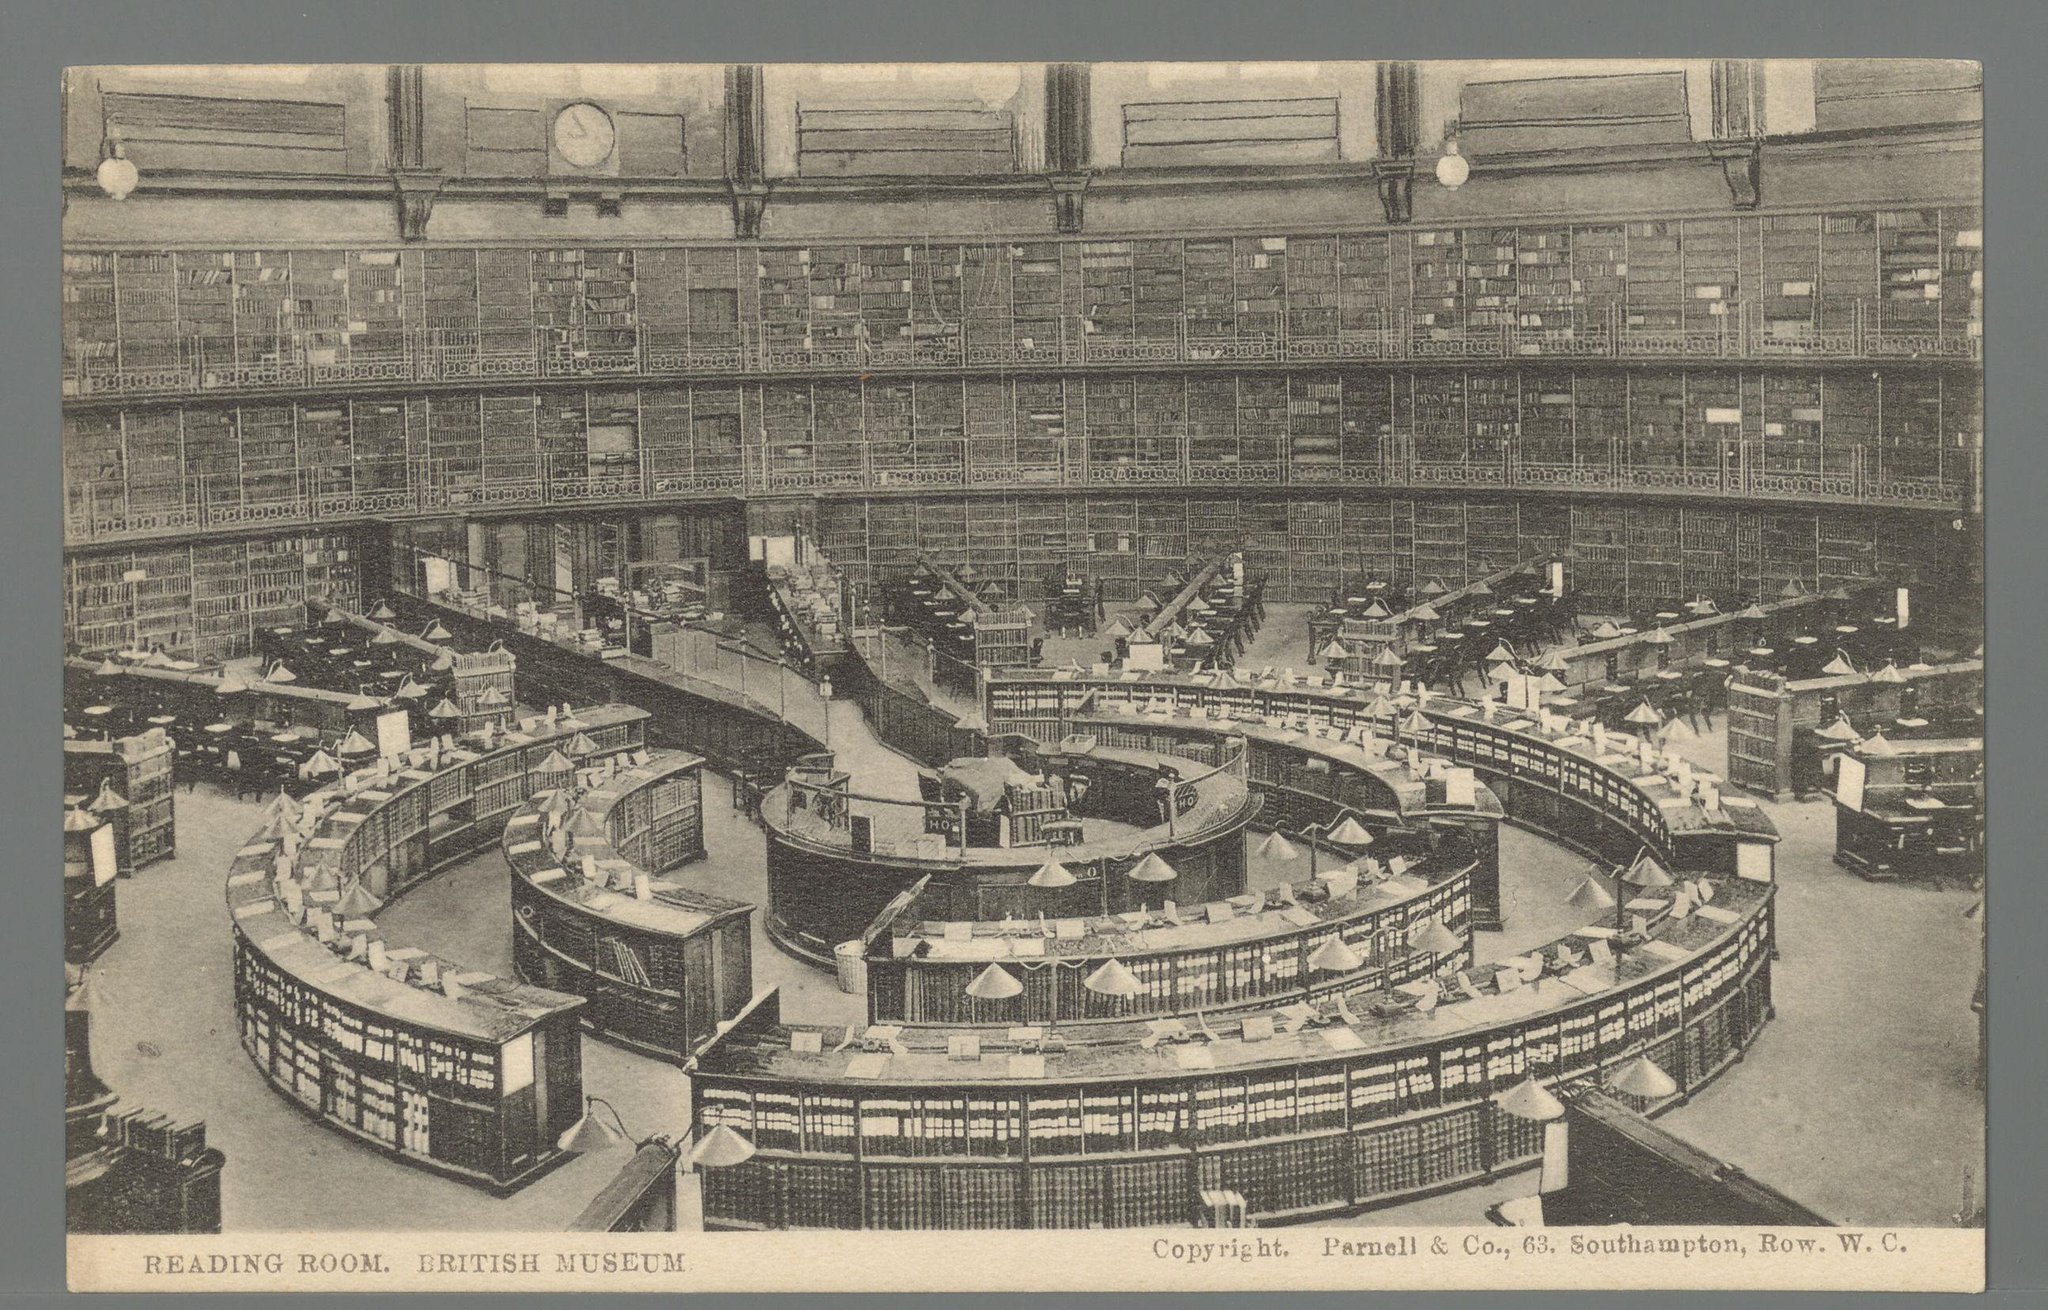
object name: photomechanical print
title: Reading Room. British Museum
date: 1902-1930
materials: cardboard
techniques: photograph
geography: london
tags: study; 'studiolo'; library, permanent exhibition, museum